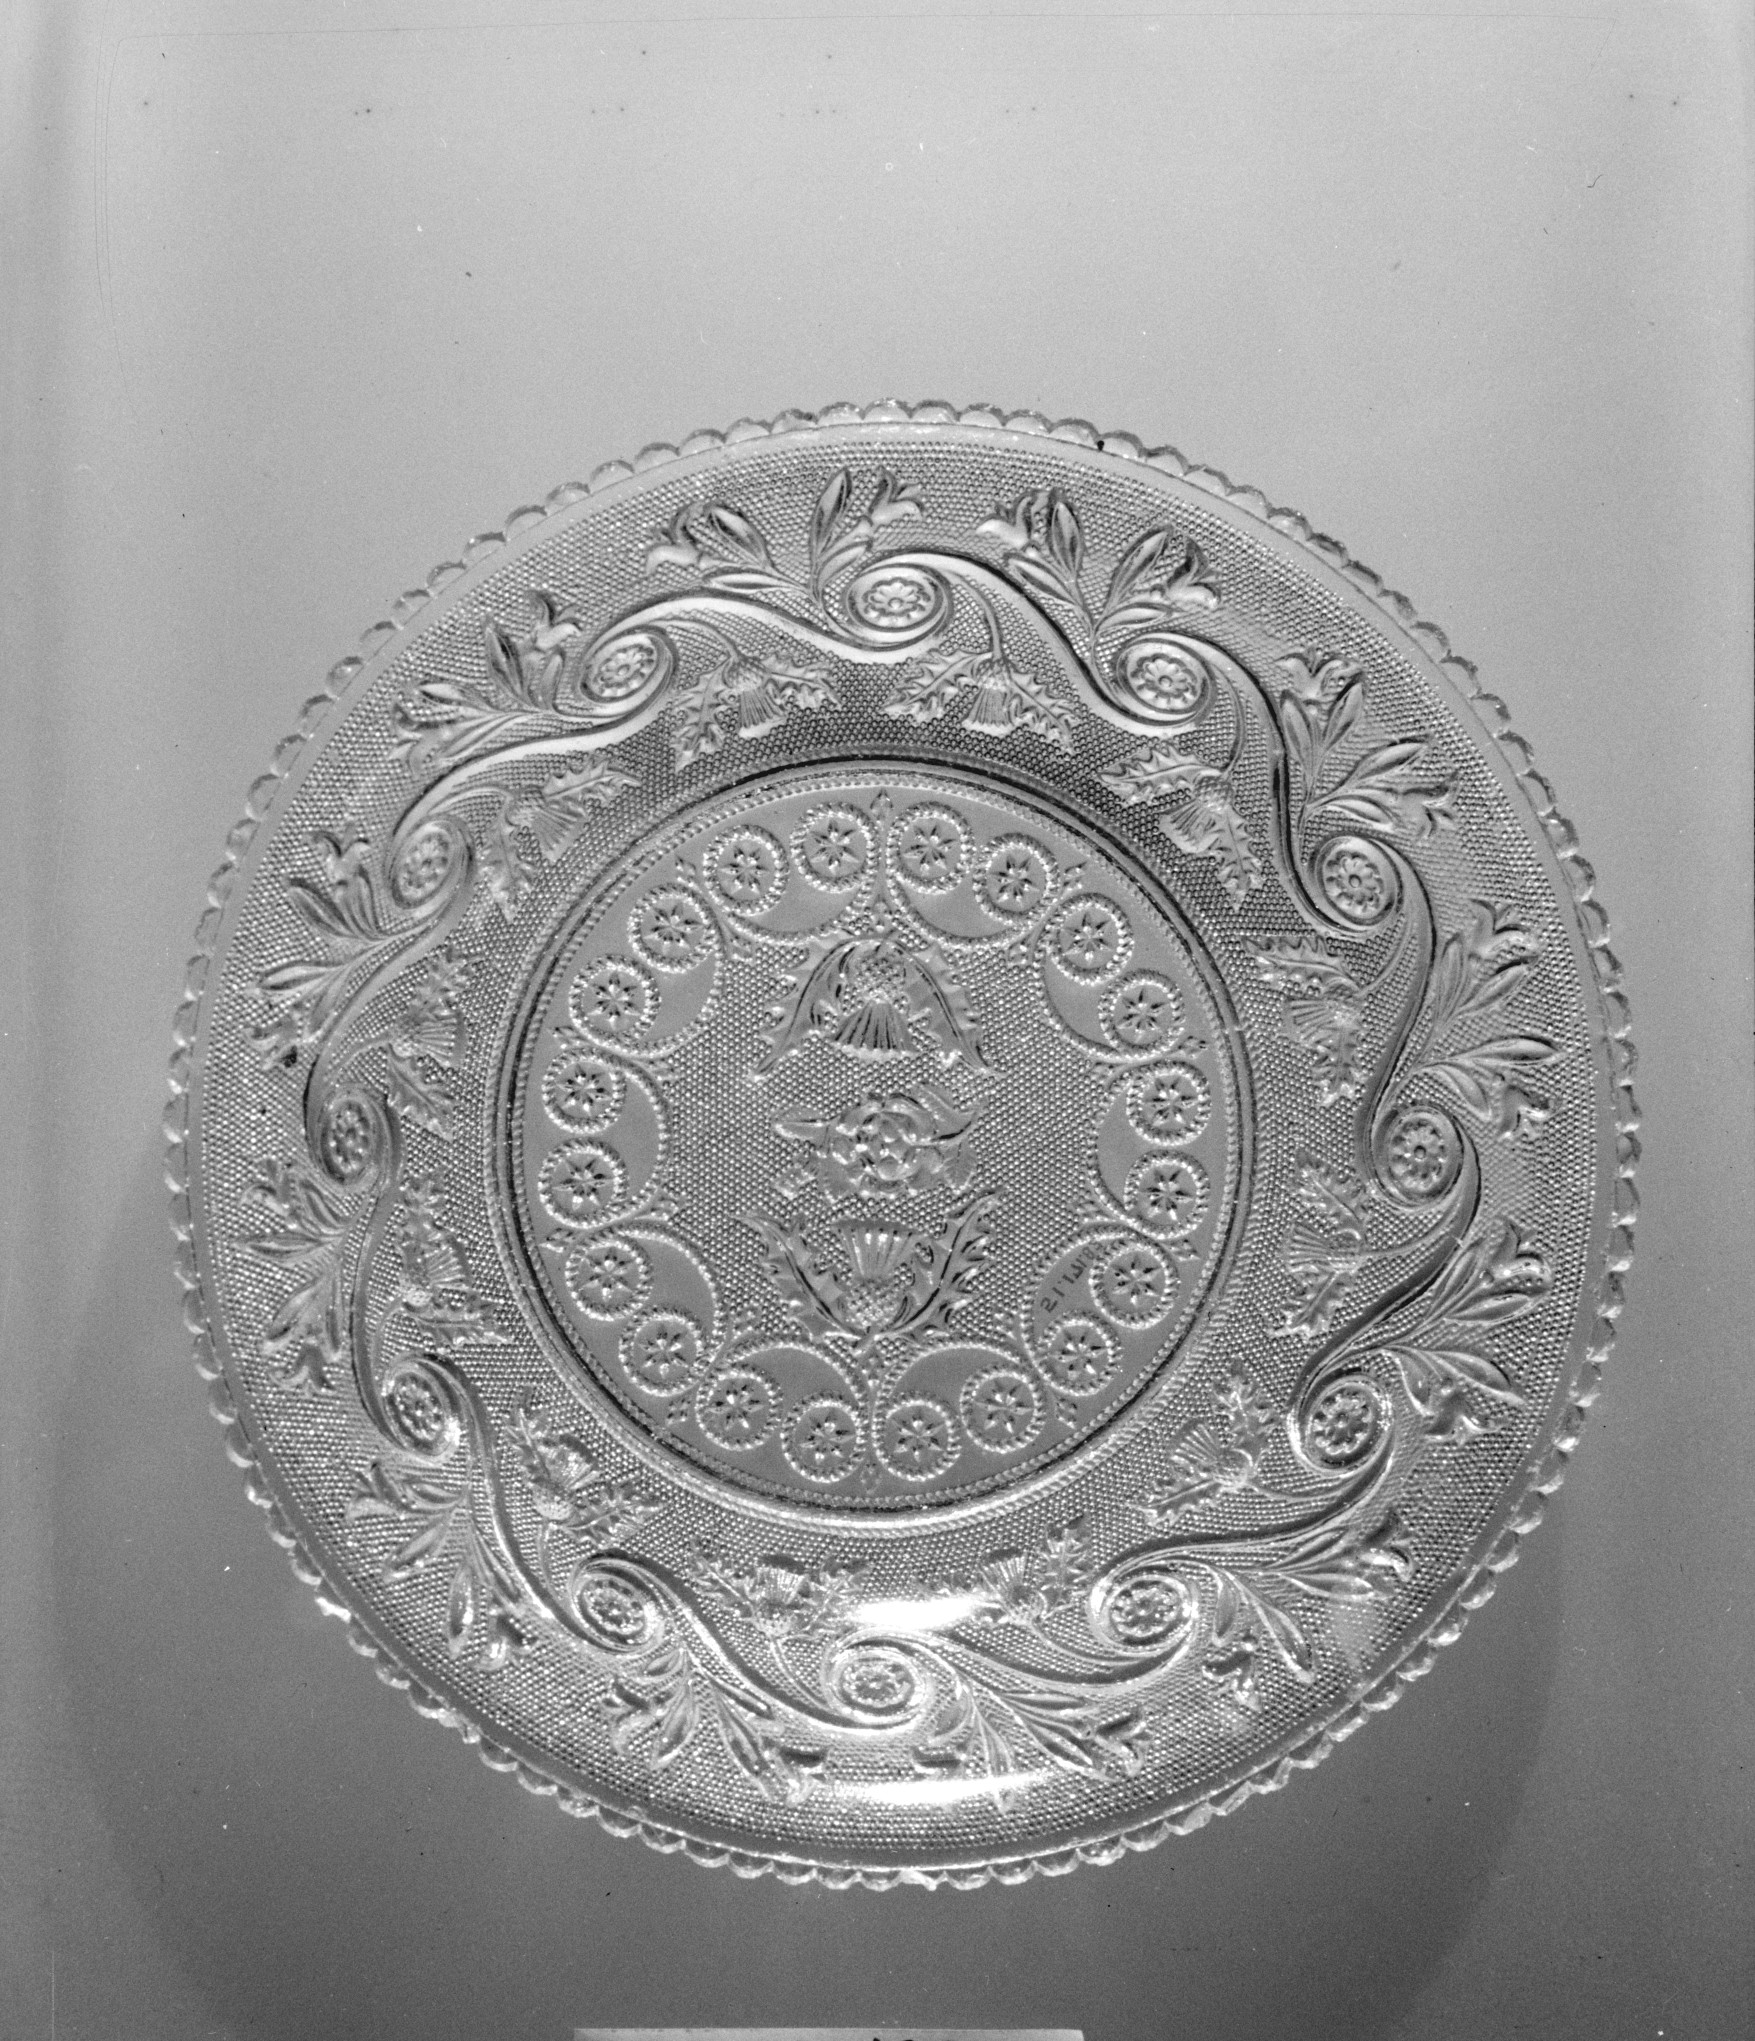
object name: bowl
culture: american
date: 1830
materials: glass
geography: united states